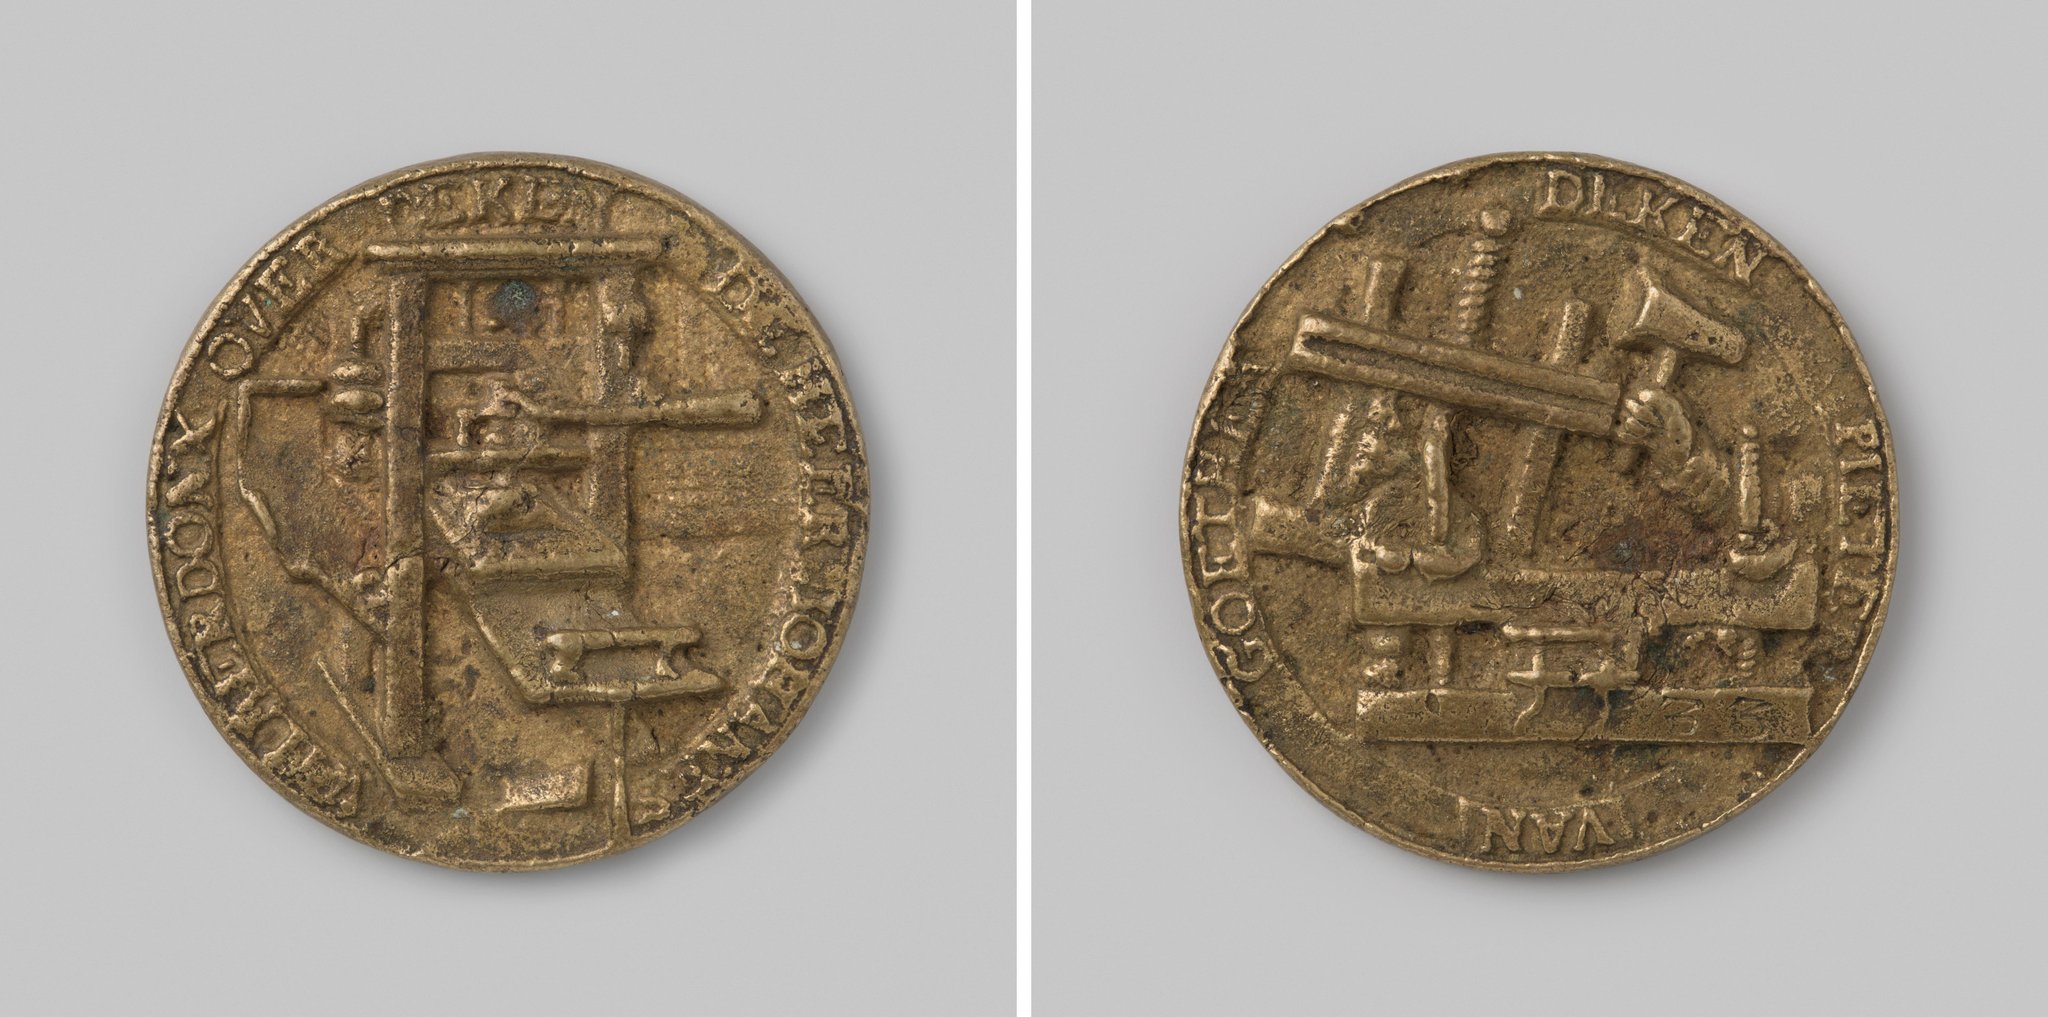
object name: history medal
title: Presentiepenning van het Boekdrukkersgilde te Middelburg 1662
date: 1662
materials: brass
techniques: casting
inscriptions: circumscription: ‘DE HEER IOHANES - WILMERDONX OVER DEKEN’, inscription: ‘33’, circumscription: ‘PIETER - VAN GOETHEM - DEKEN’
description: Gegoten messing penning, op de voorzijde een drukpers met omschrift, op de keerzijde een boekenpers, een hand met hamer en een boekenklem met boek, met omschrift en gegraveerd nummer 33